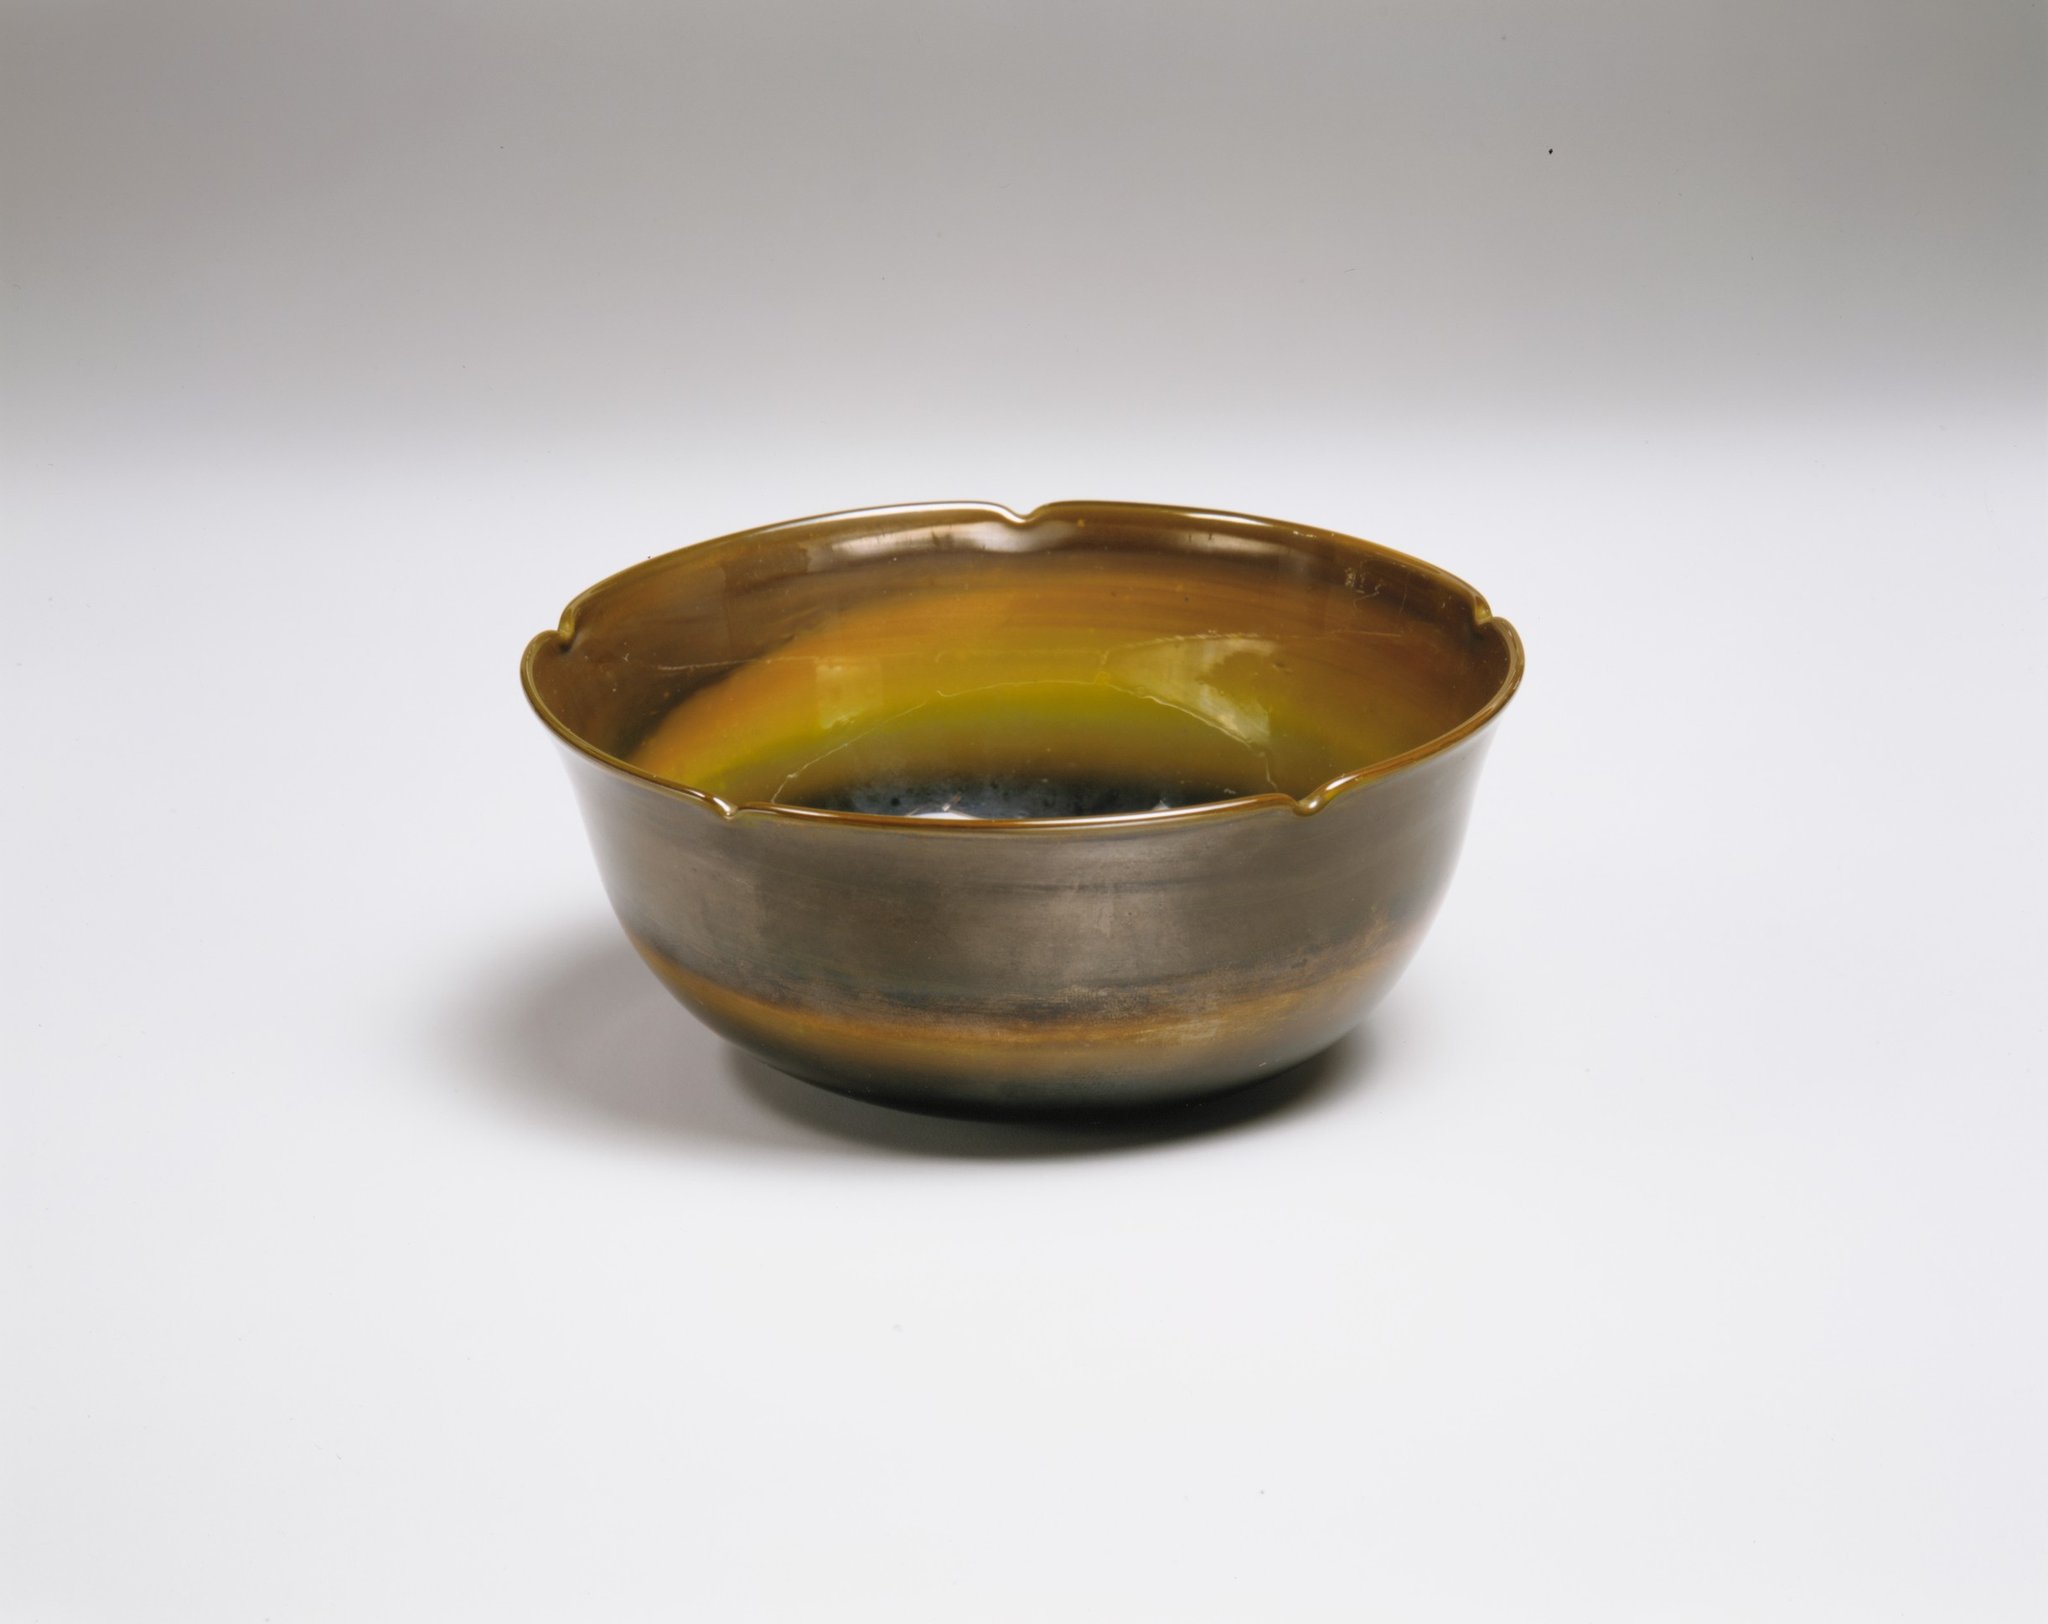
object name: bowl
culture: american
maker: louis c. tiffany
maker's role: designer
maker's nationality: american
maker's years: 1848-1933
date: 1893-1896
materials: glass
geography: united states